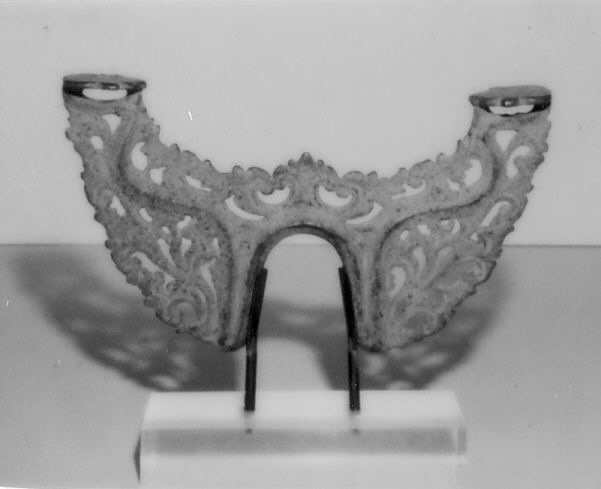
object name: suspension part for a musical instrument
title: Suspension Part for a Musical Instrument called "Gender"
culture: indonesian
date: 901-1100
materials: bronze